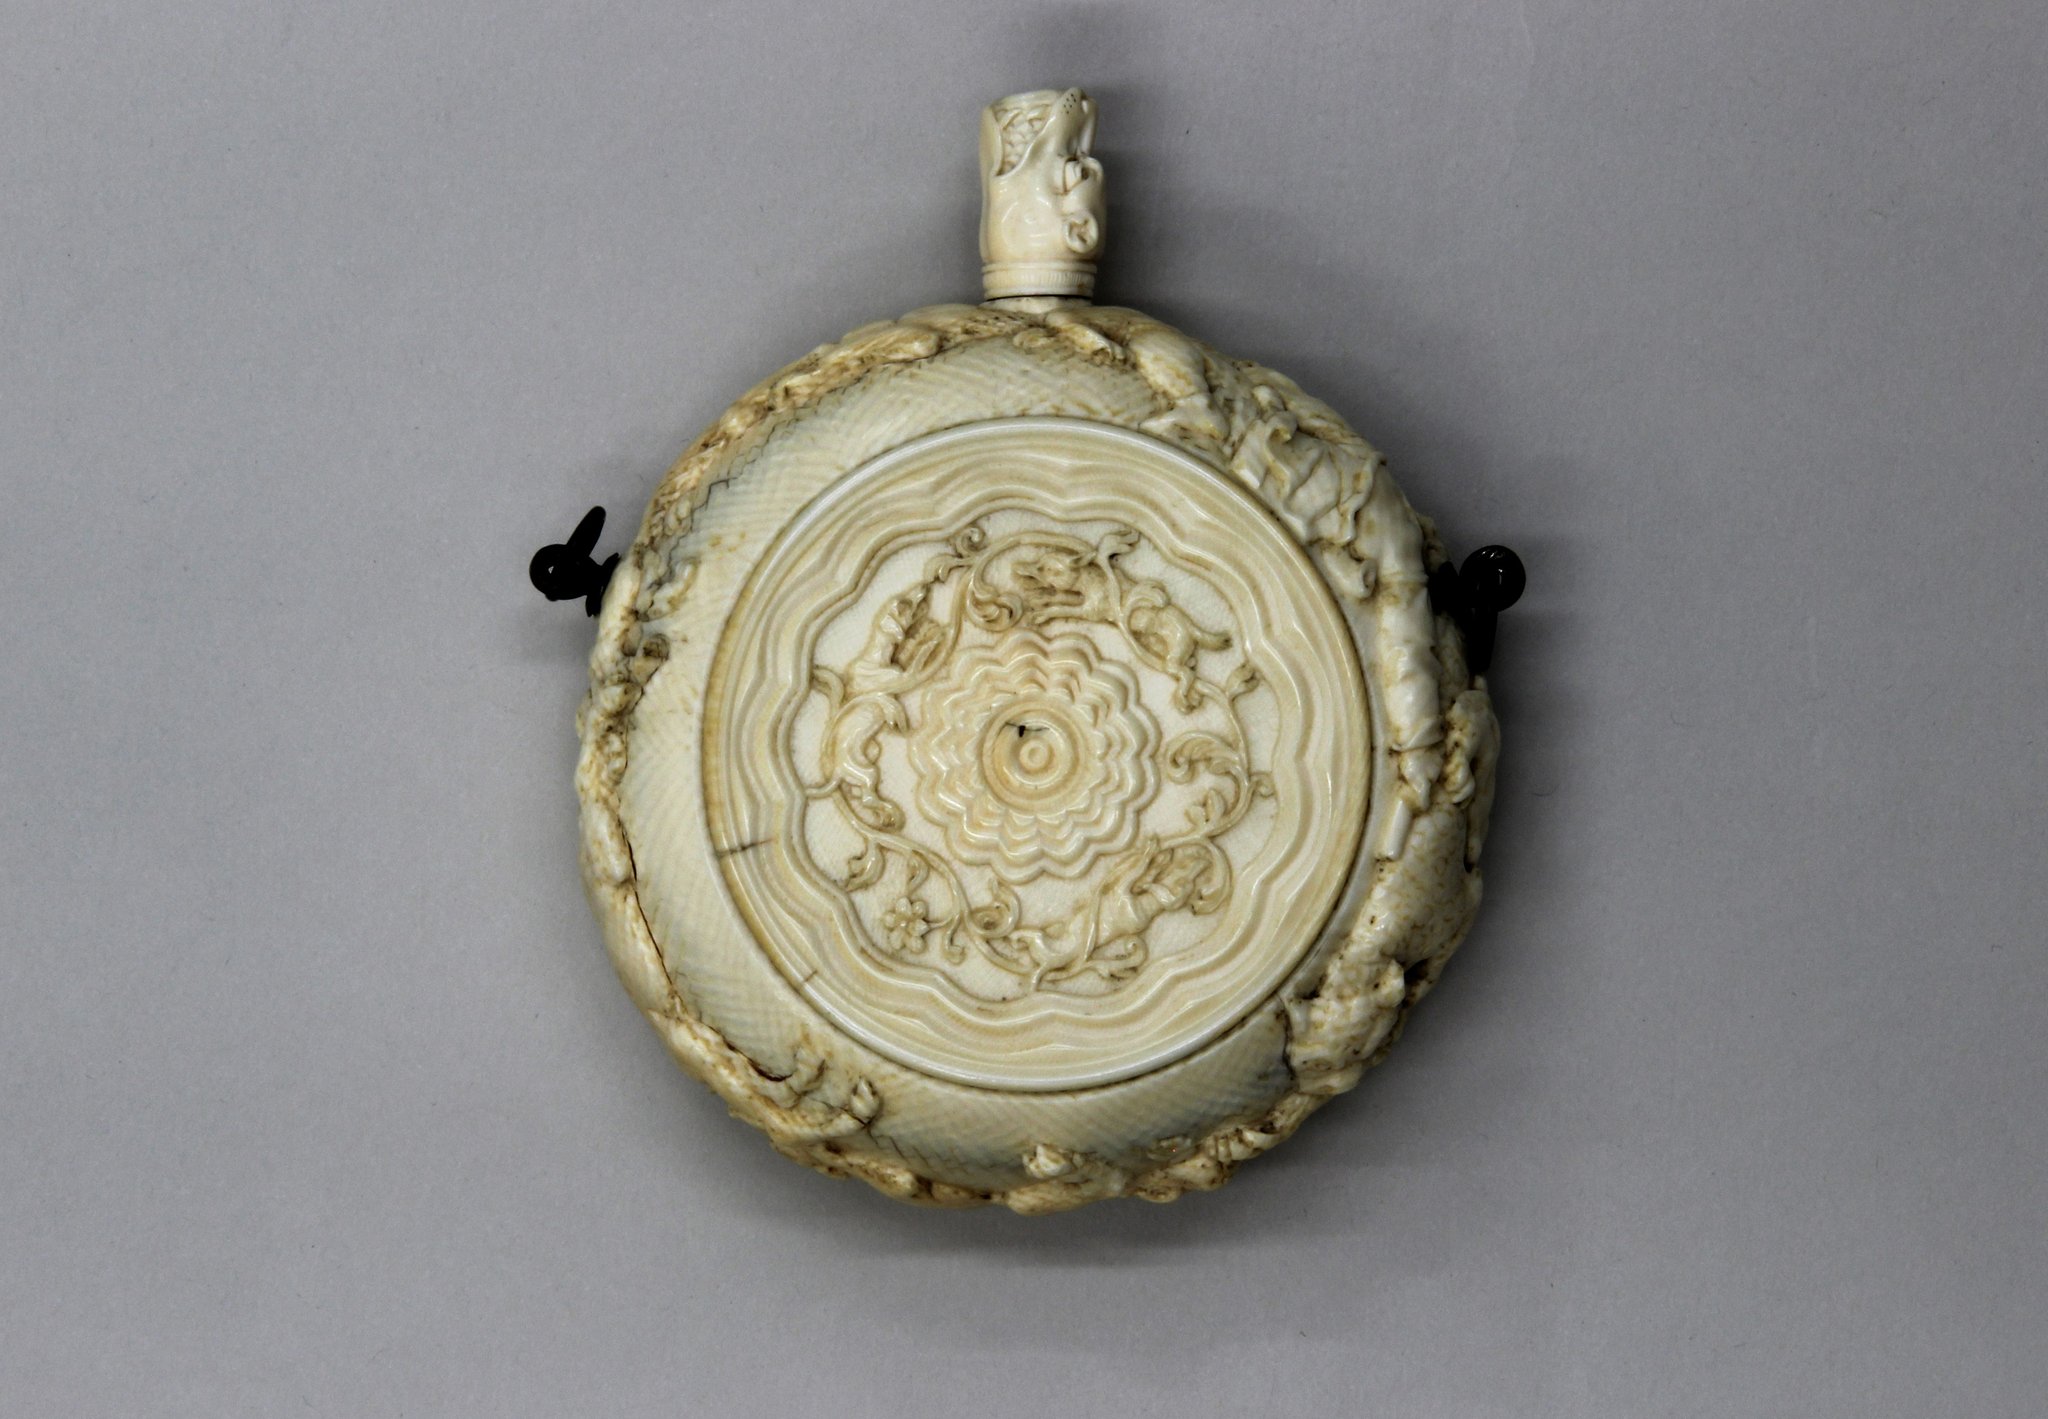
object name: powder flask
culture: german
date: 1670-1680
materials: copper alloy, ivory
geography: germany